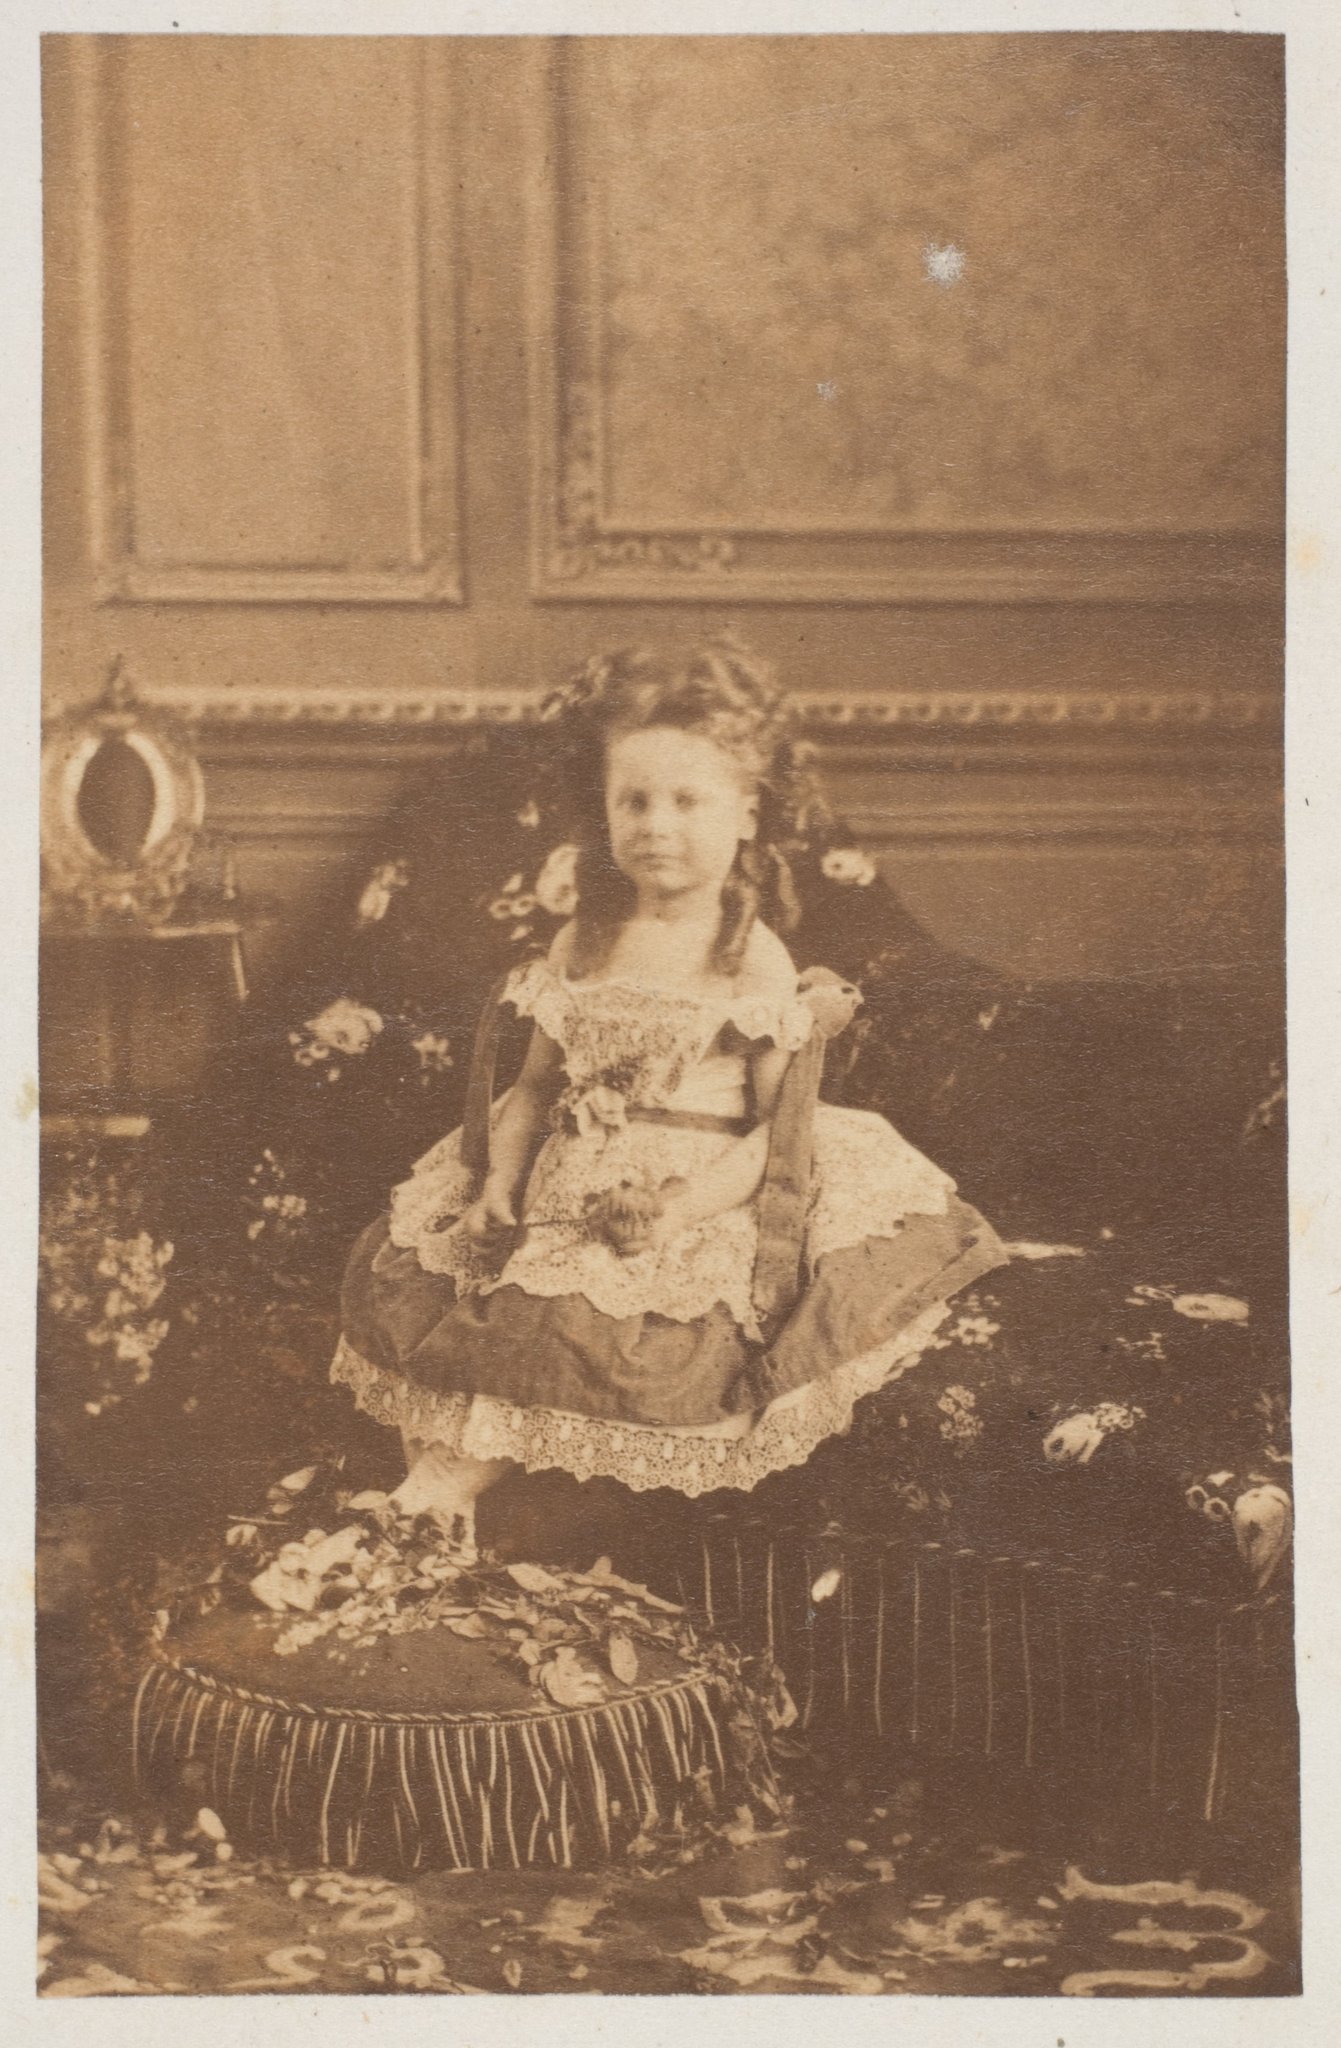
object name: photograph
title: Le fauteuil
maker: pierre-louis pierson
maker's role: artist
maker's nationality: french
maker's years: 1822-1913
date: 1860-1869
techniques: albumen silver print, glass negative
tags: girls,portraits